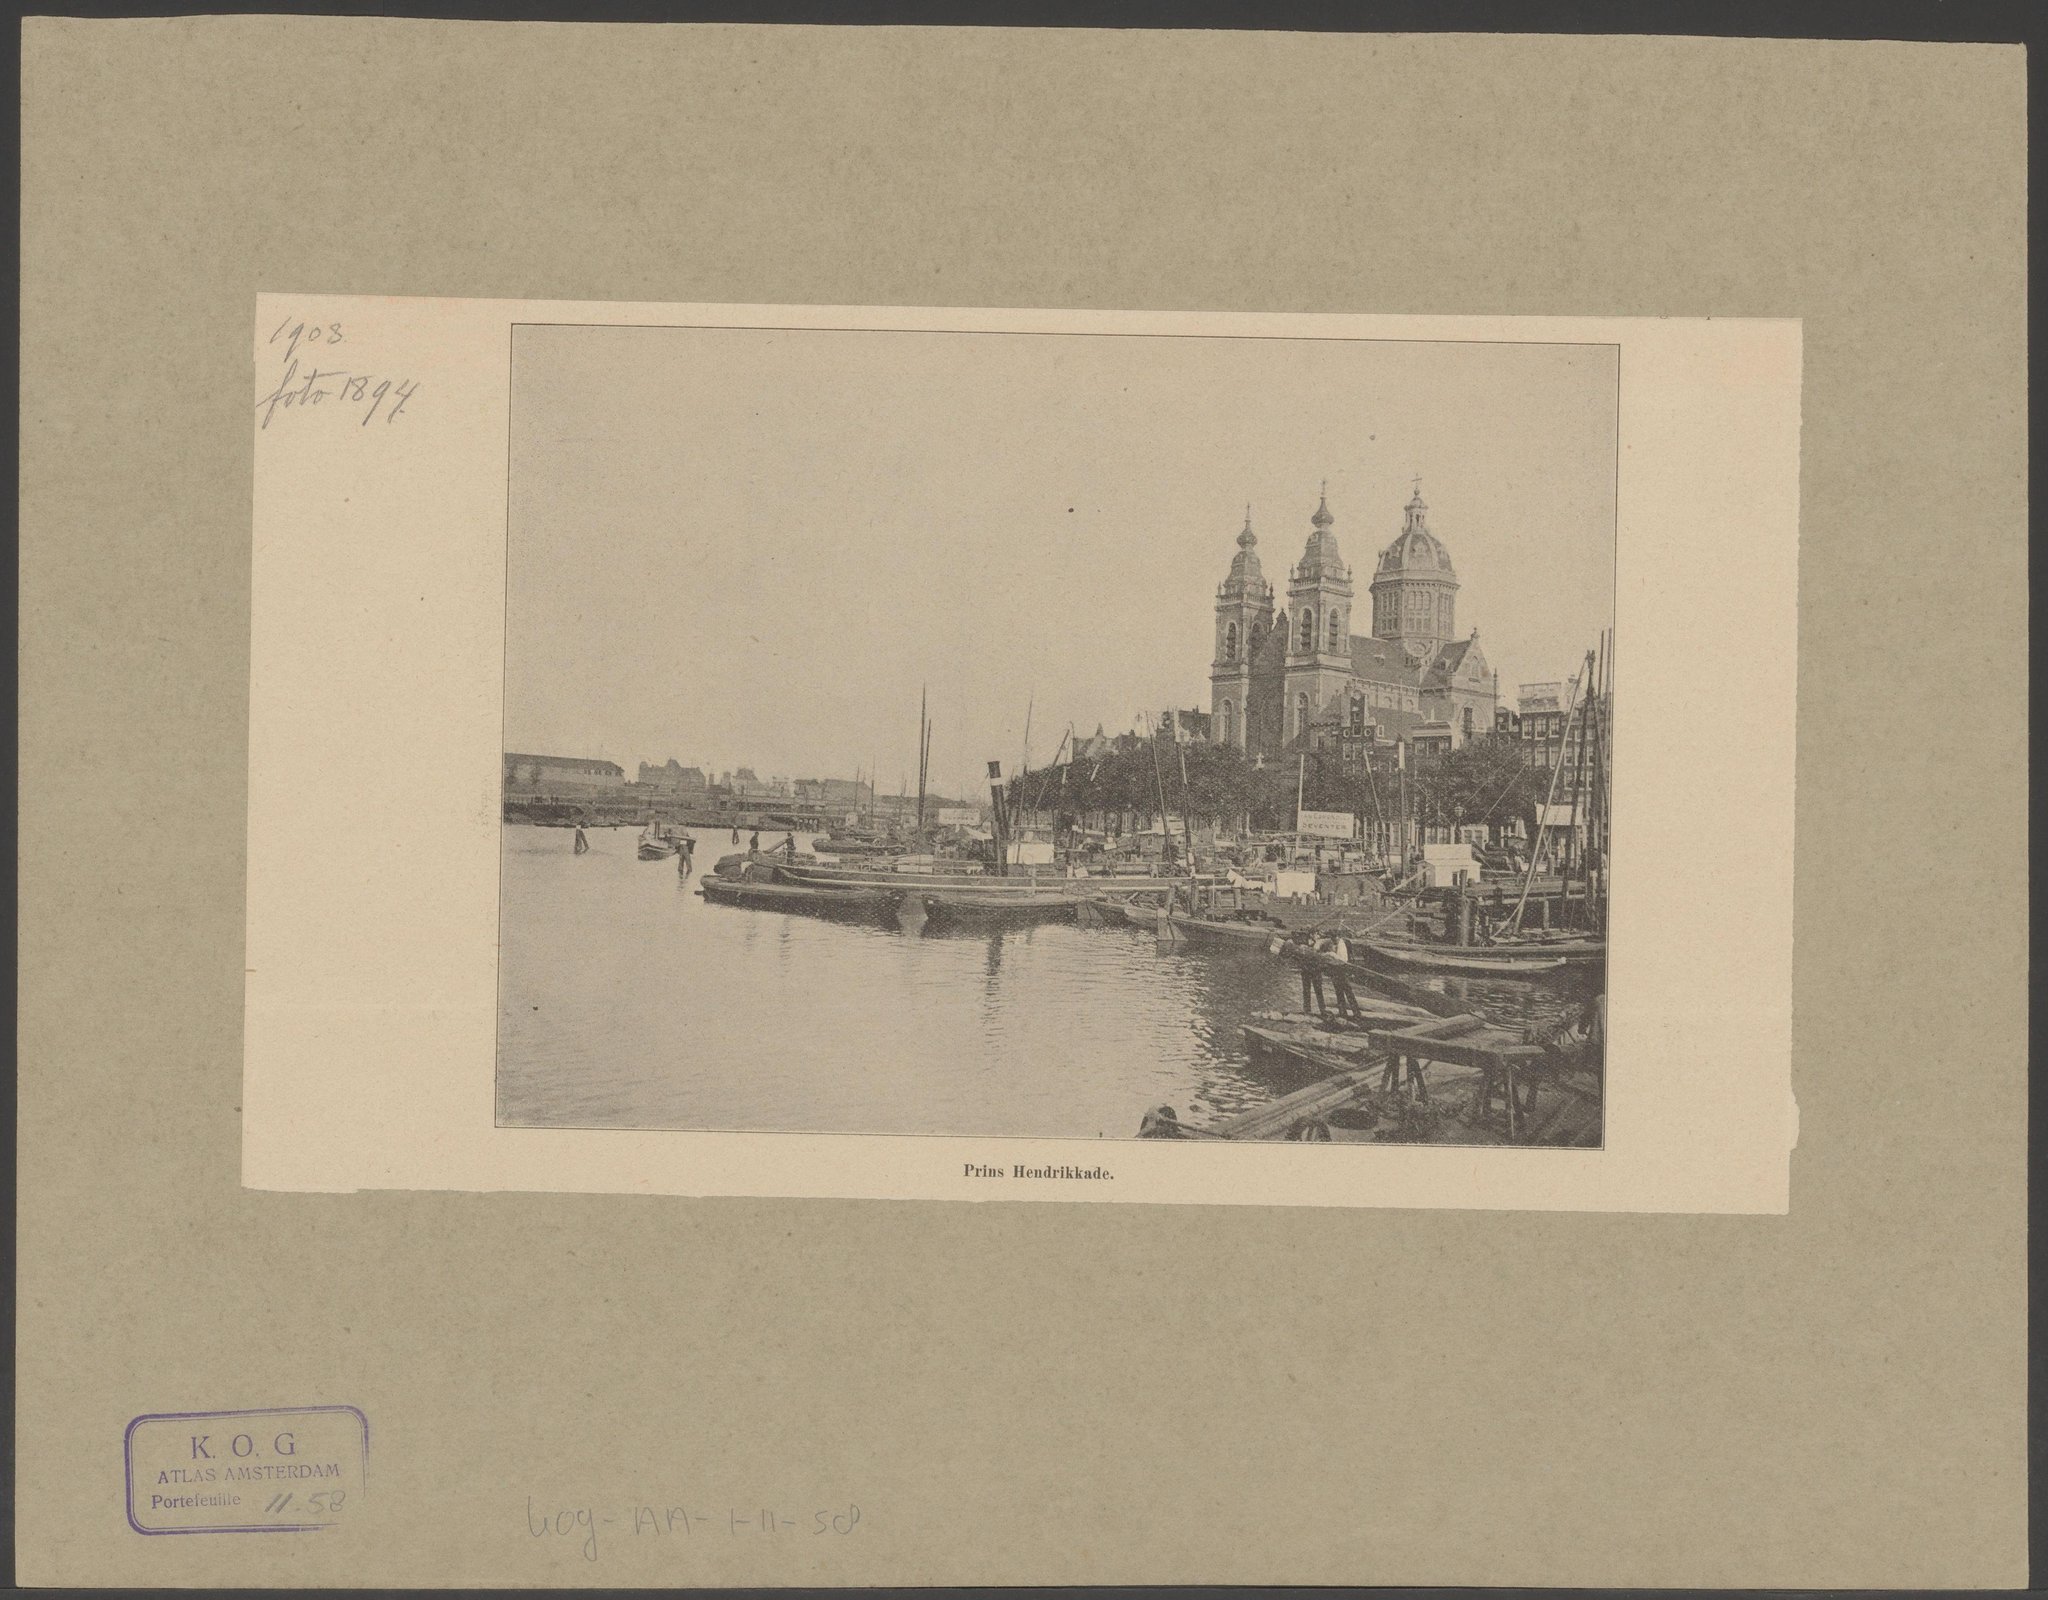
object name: photomechanical print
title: Gezicht op de Prins Hendrikkade en de Basiliek van de Heilige Nicolaas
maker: Anonymous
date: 1908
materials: paper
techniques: letterpress printing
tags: city-view in general; 'veduta', river, church (exterior)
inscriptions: collector's mark: ‘11.58’ Lugt 1641b, date: ‘1908 / foto 1894.’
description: Onderwerpsrubriek binnen de Atlas Amsterdam: Prinsengracht, Korte Prinsengracht, Prins Hendrikkade. Zie ook Portefeuille 1: gezichten van het IJ op de stad.